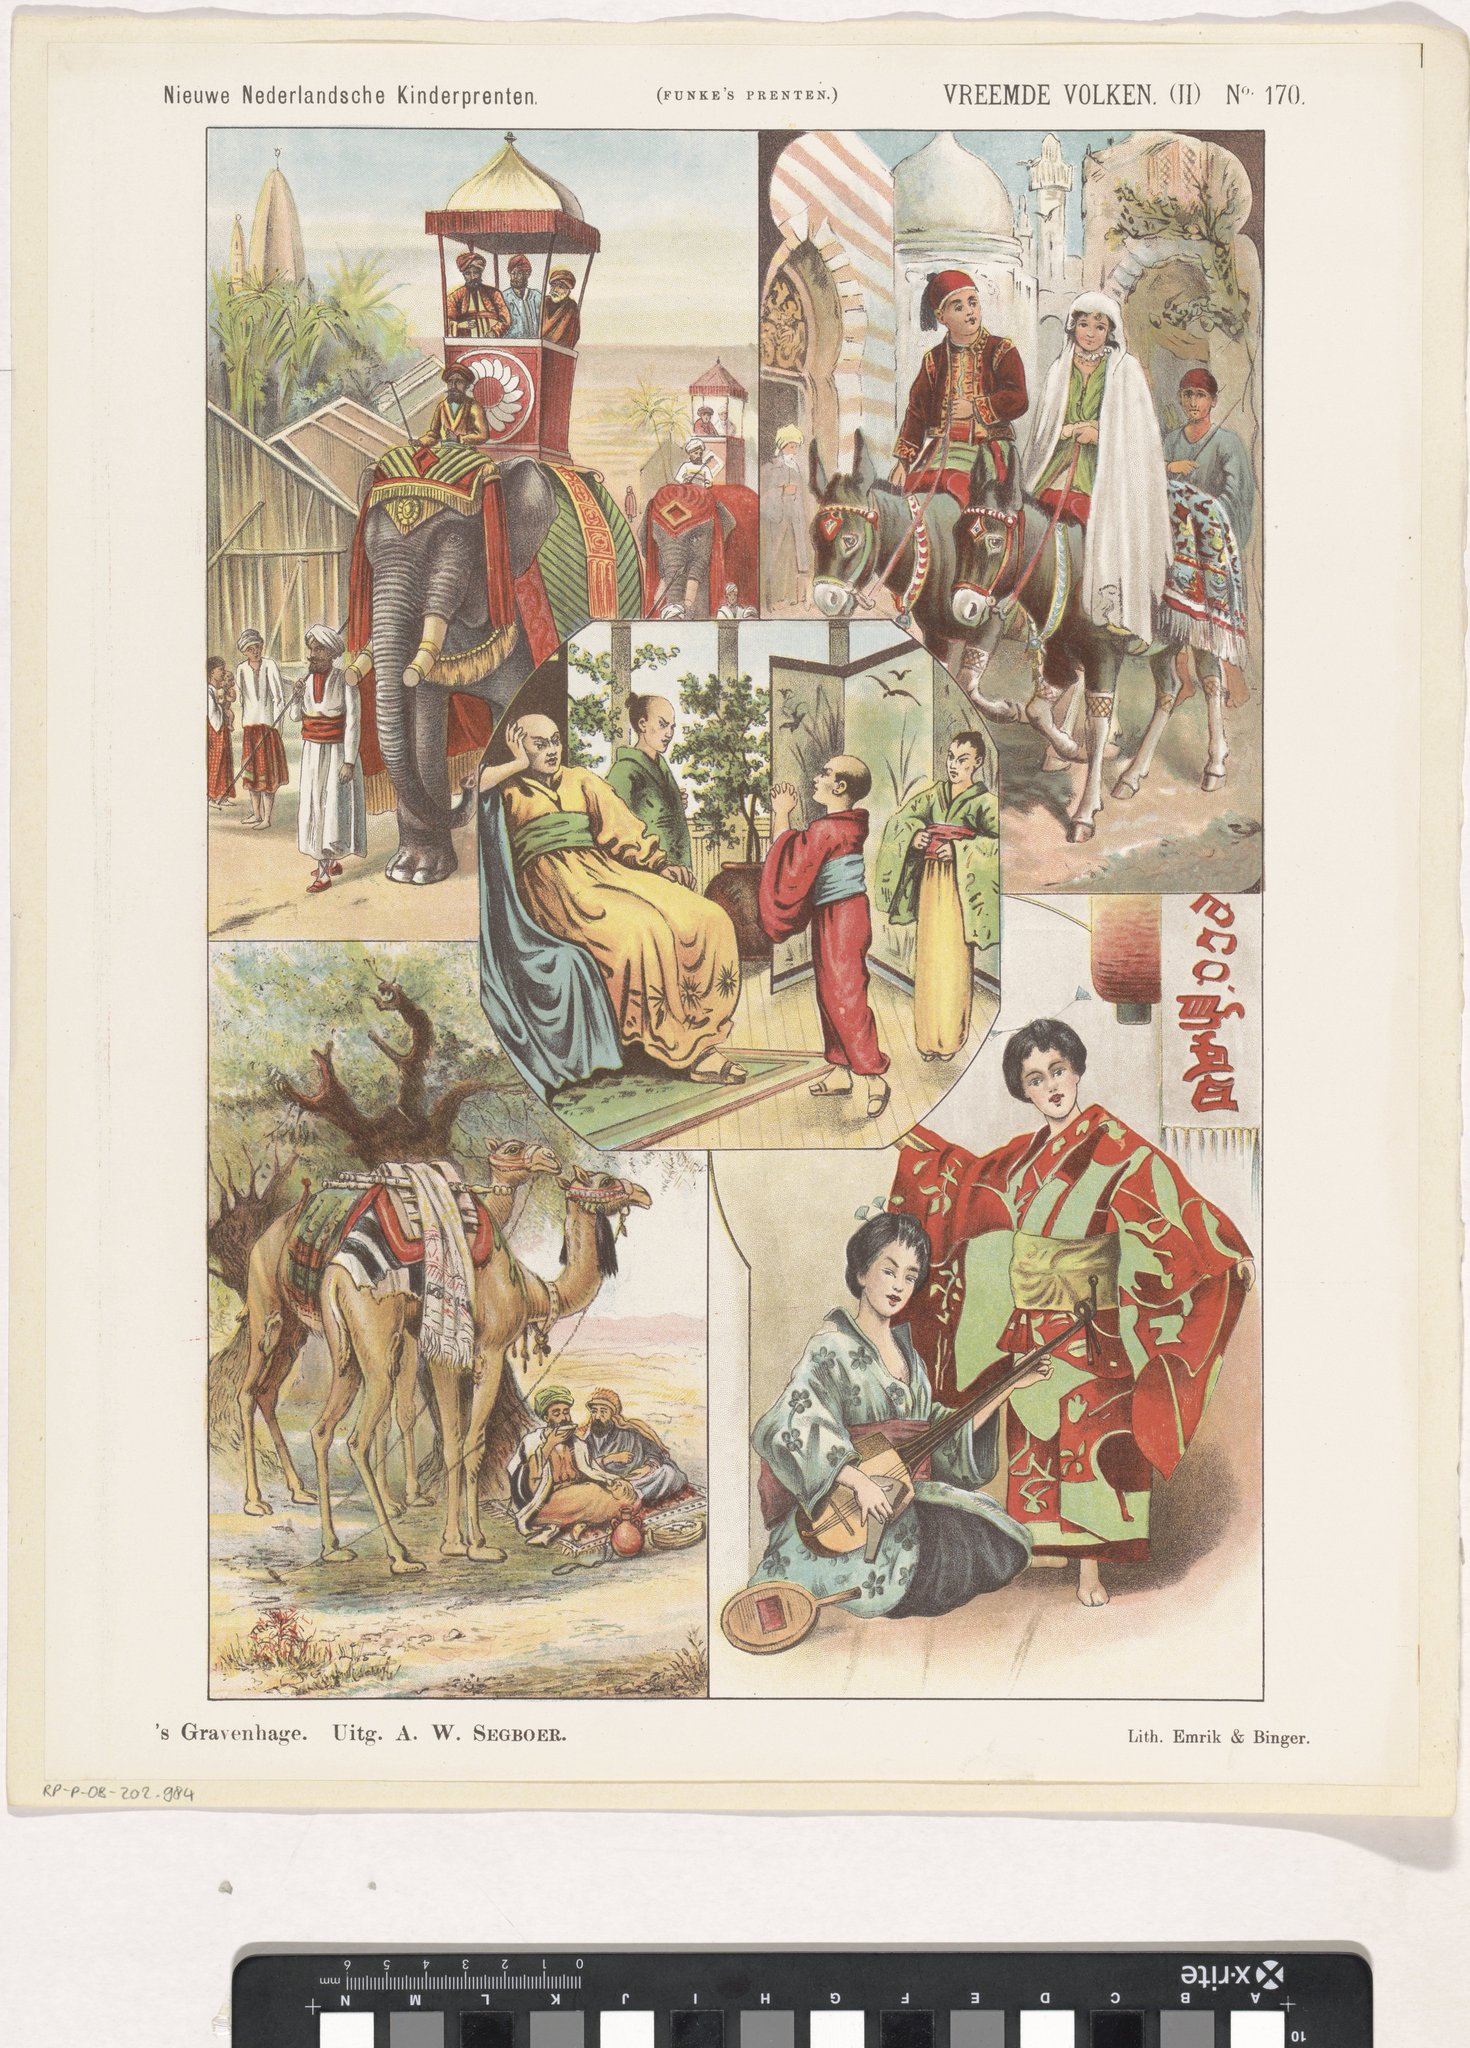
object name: print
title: Vreemde volken (II)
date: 1903-1919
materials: paper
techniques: lithograph, letterpress printing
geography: the hague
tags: asiatic races and peoples, human races; peoples; nationalities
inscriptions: collector's mark: Lugt 2760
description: Blad met 5 voorstellingen van Aziatische volken. Genummerd rechtsboven: No. 170.